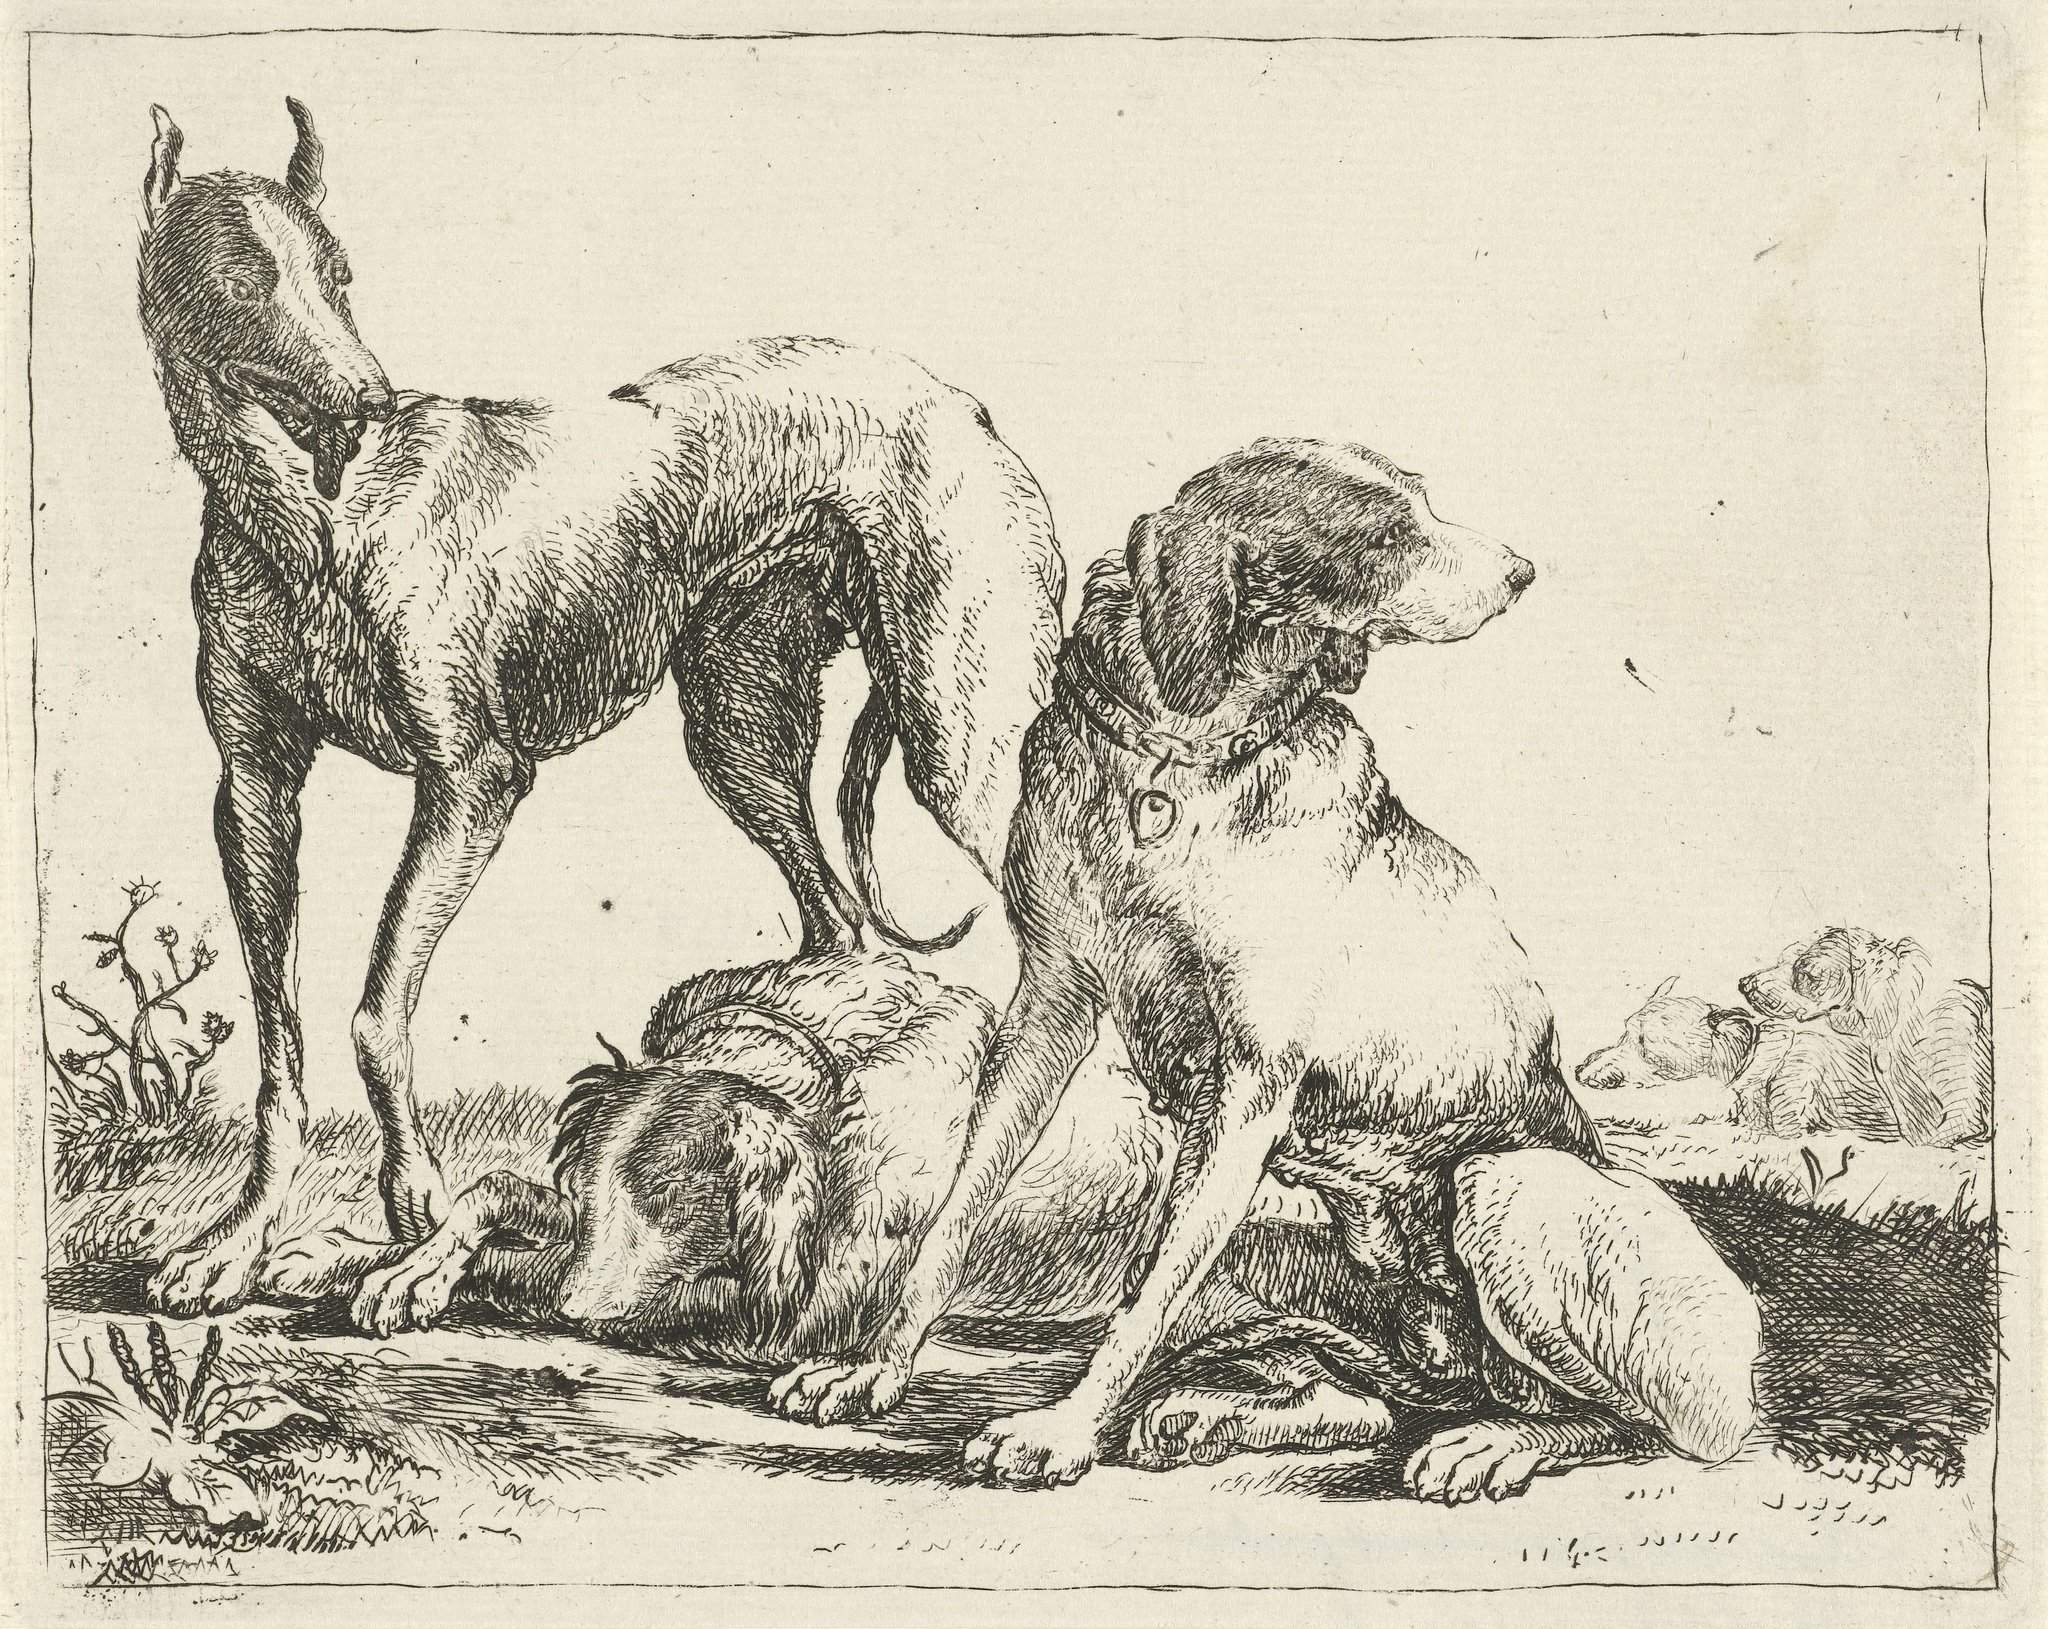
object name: print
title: Drie honden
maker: pauwels van hillegaert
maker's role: painter, print maker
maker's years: 1596-1658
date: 1606-1658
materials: paper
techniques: etching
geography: amsterdam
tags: dog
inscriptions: collector's mark: Lugt 2228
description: Drie honden in een landschap. Op de achtergrond nog twee honden. Tweede prent van een serie van vier prenten met voorstellingen van honden.